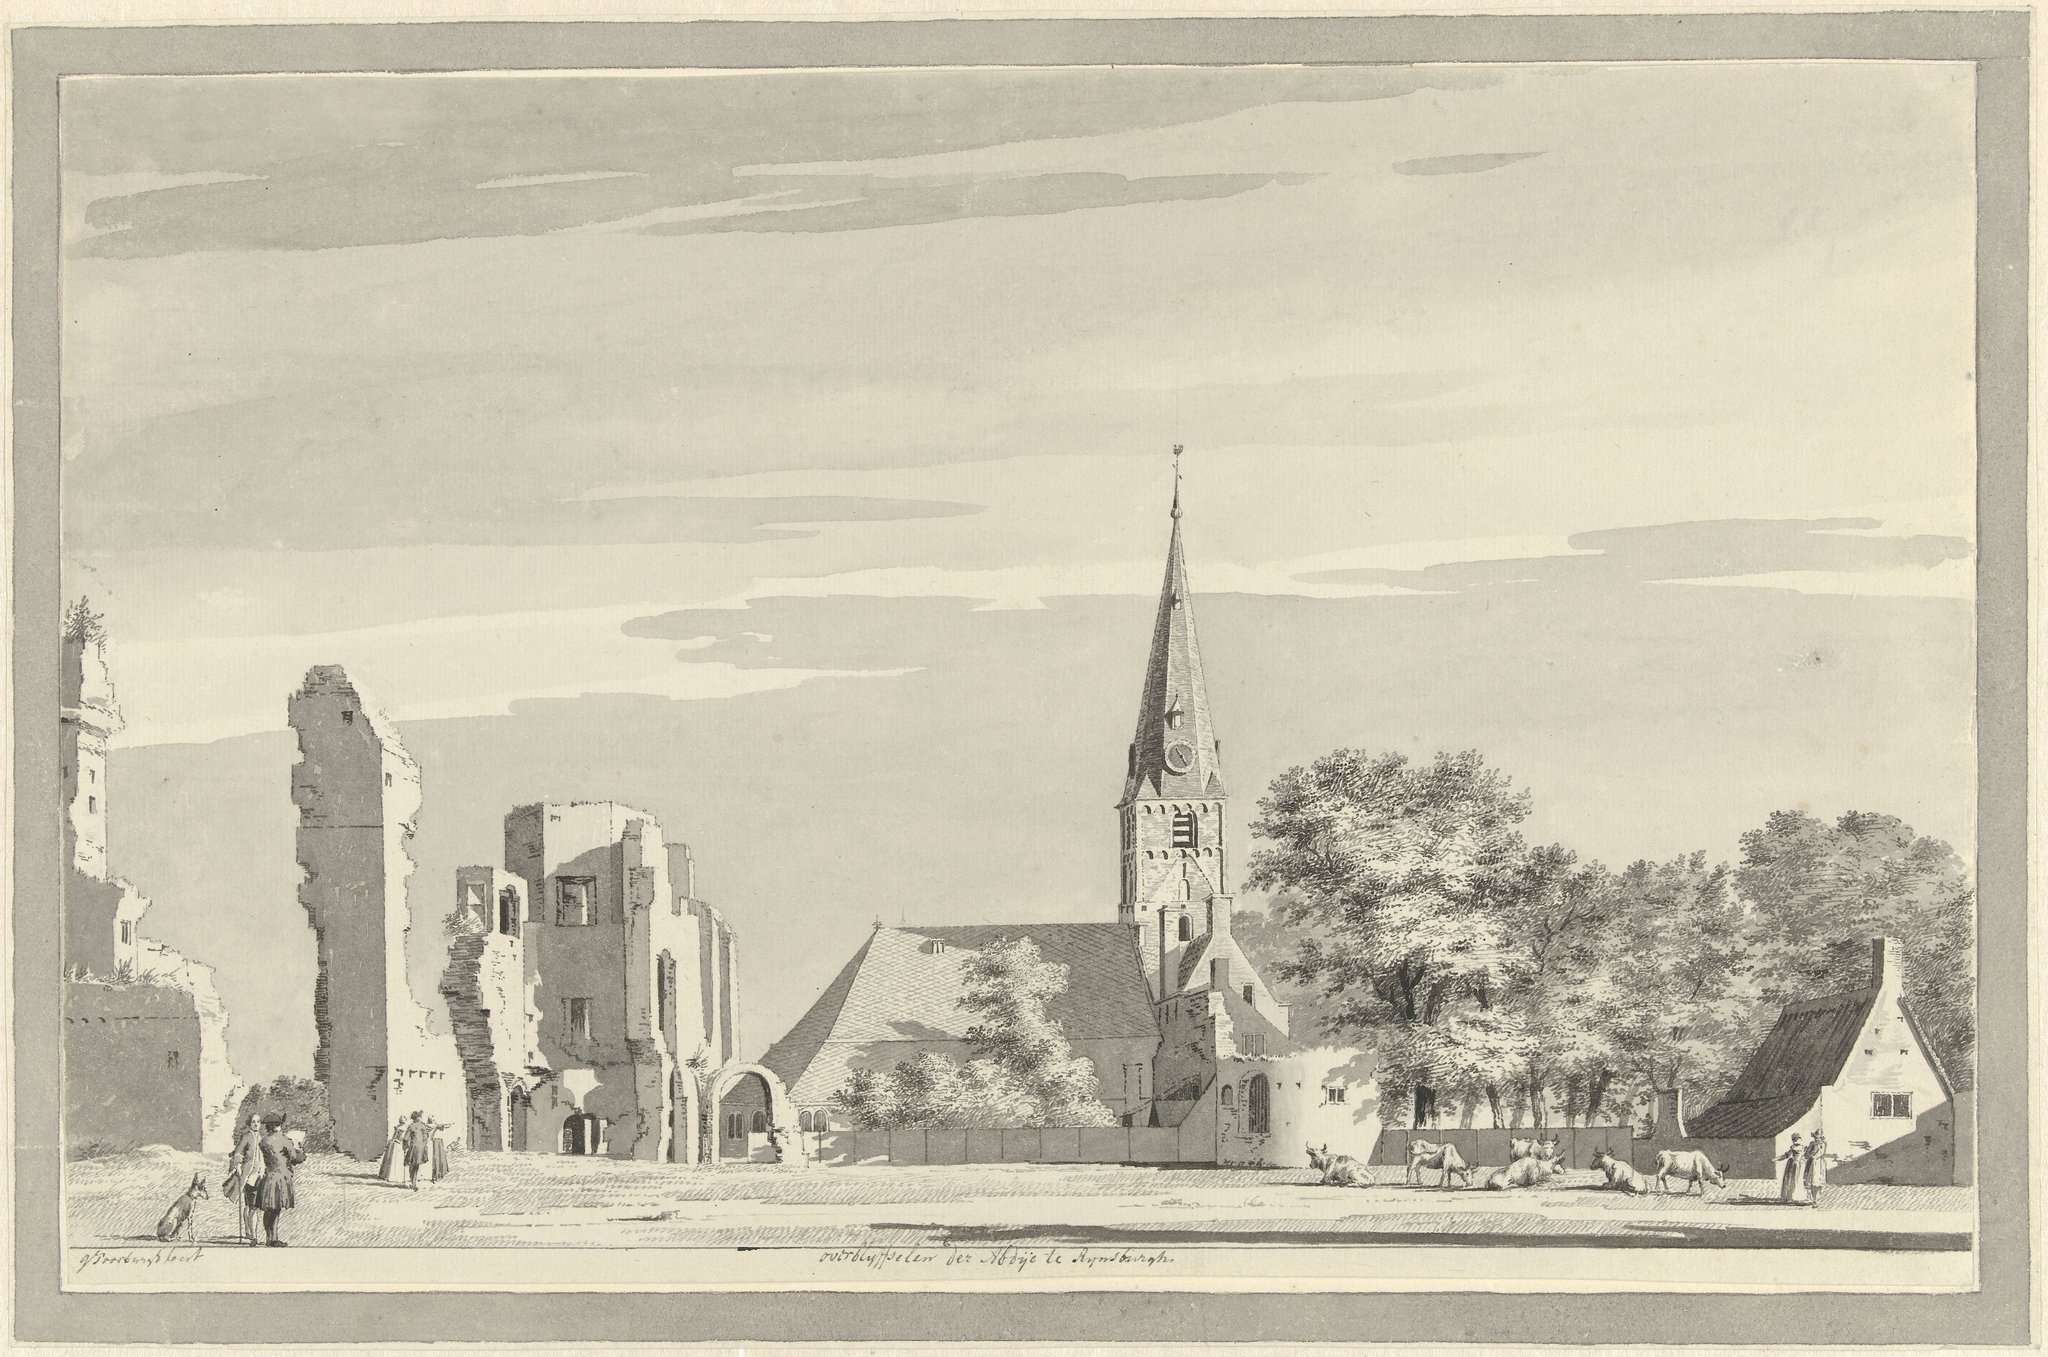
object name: drawing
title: overblyffselen der Abdije te Rijnsburgh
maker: gerrit toorenburgh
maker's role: draughtsman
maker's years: 1732-1785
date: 1742-1785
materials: ink, paper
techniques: brush, pen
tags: ruin of church, monastery, etc.